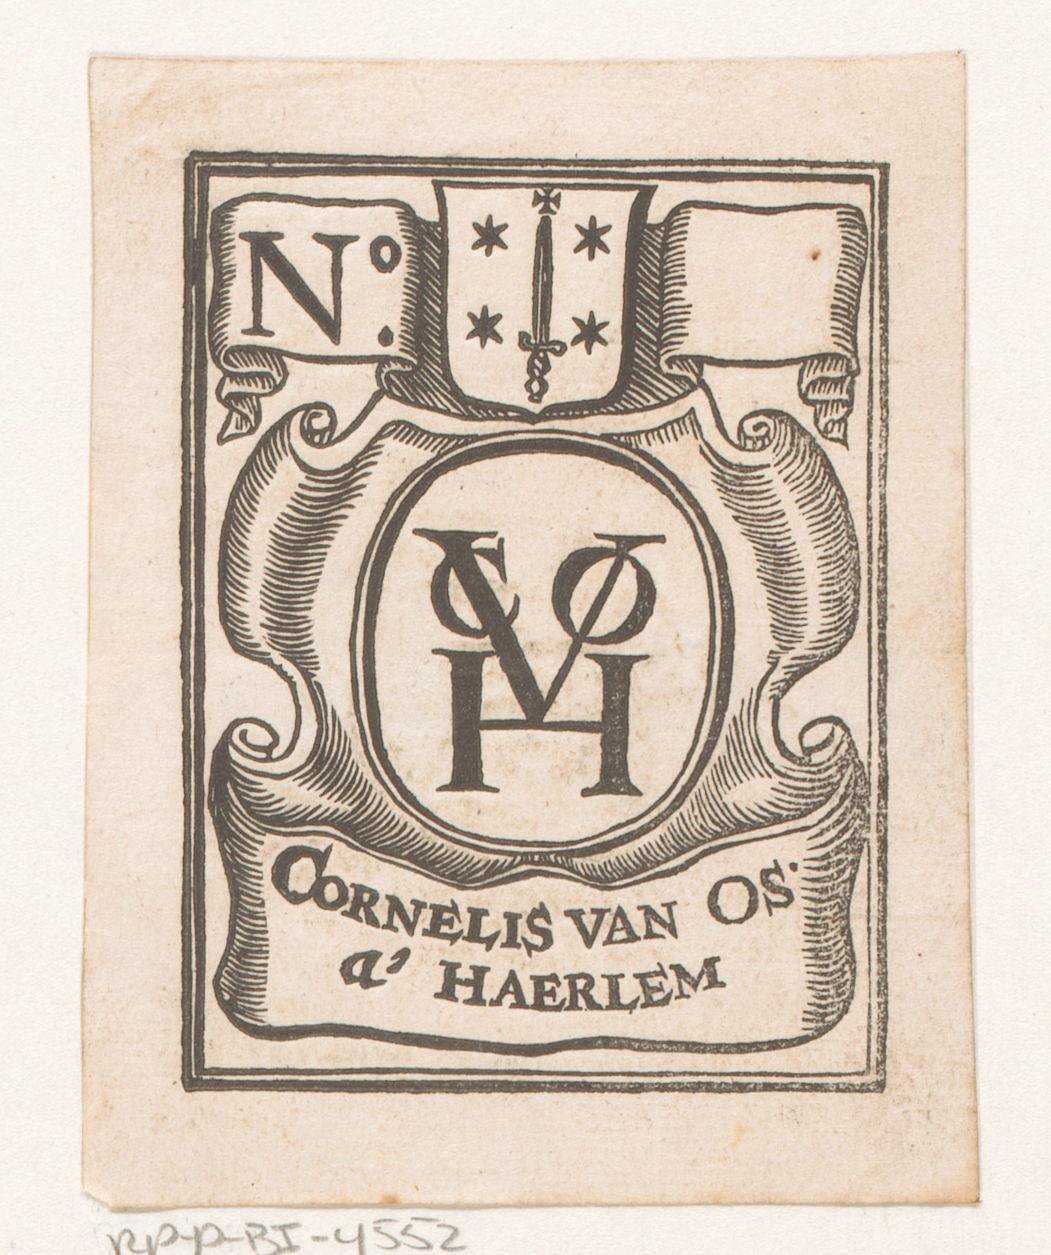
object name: print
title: Vignet van Cornelis van Os te Haarlem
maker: Anonymous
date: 1600-1699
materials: paper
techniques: woodcut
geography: netherlands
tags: coat of arms (as symbol of the state, etc.) (+ city; municipal), vignette, letter combinations such as letterword, anagram, letter square, monogram, etc., haarlem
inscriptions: collector's mark: Lugt 240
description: Het monogram van Cornelis van Os in een geornamenteerde omlijsting. Midden boven het wapen van de stad Haarlem.